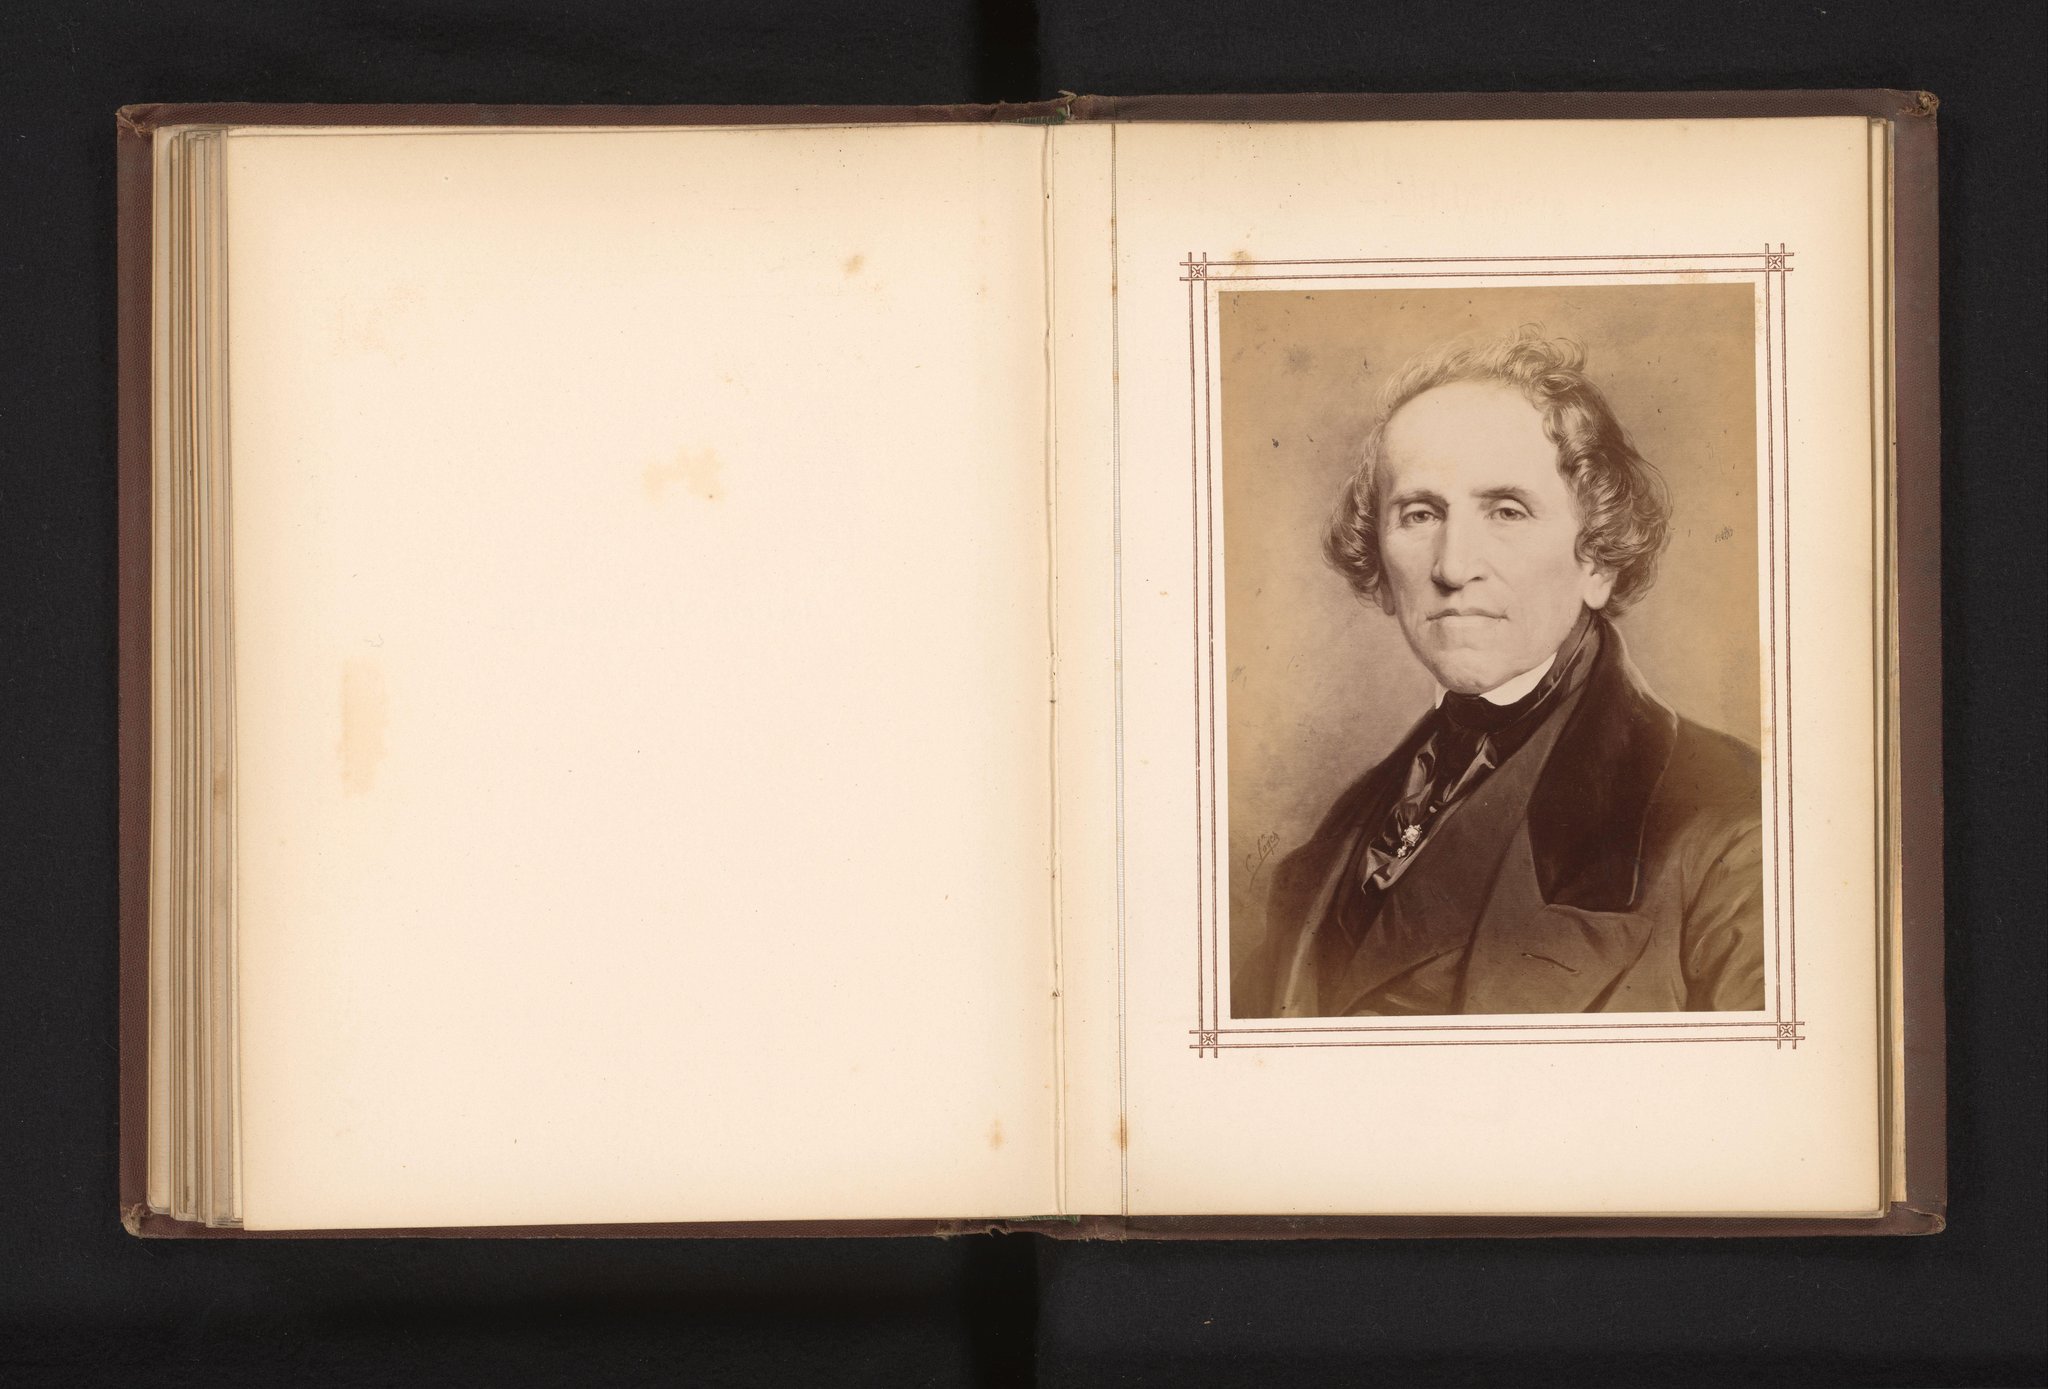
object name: page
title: Fotoreproductie van een portret van Giacomo Meyerbeer door Carl Jaeger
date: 1865-1875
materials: photographic support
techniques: albumen print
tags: berlin, giacomo meyerbeer, composer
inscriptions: name: ‘C. Jäger’